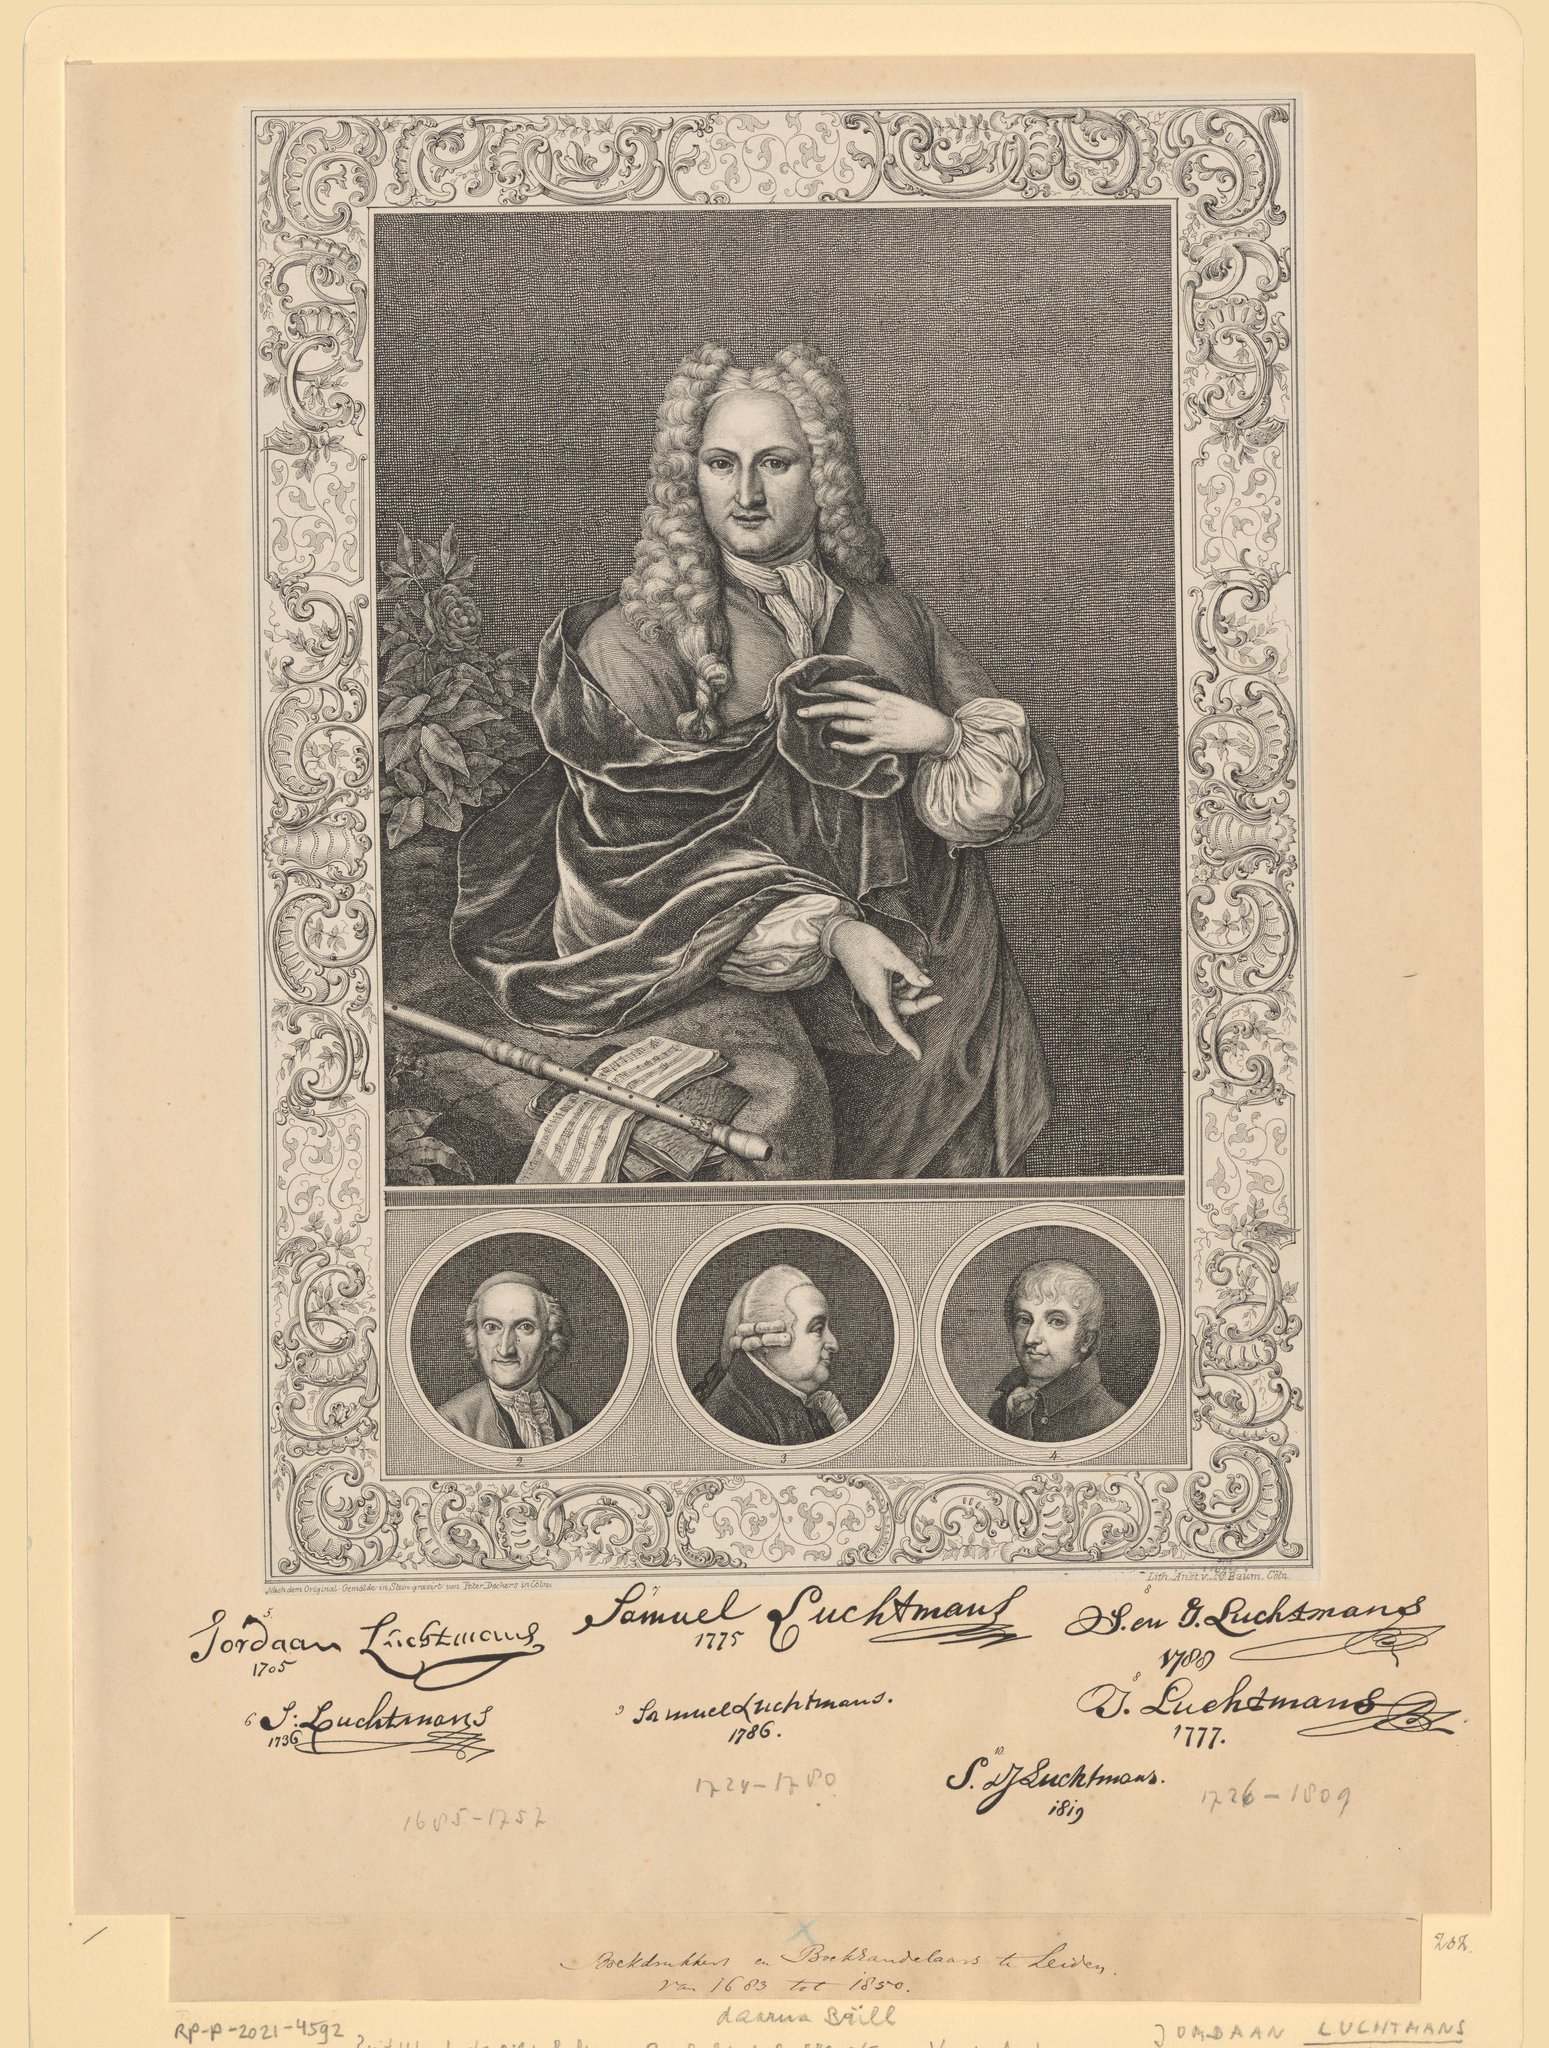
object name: print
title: Portret van Samuel I Luchtmans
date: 1856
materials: paper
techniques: lithograph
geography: cologne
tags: publisher, samuel luchtmans (i), leiden, publishing, publisher (+ portrait of scholar, scientist), historical persons, book-shop, bookseller (+ portrait of scholar, scientist), flute, aulos, tibia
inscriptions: inscription: ‘Boekdrukkers en Boekhandelaars te Leiden./ van 1683 tot 1850’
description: Met onder het portret van Luchtmans drie portretten van Samuel II, Johannes en Samuel III Luchtmans. Onder de portretten de facsimile-handtekeningen van nog zeven leden van de familie Luchtmans.